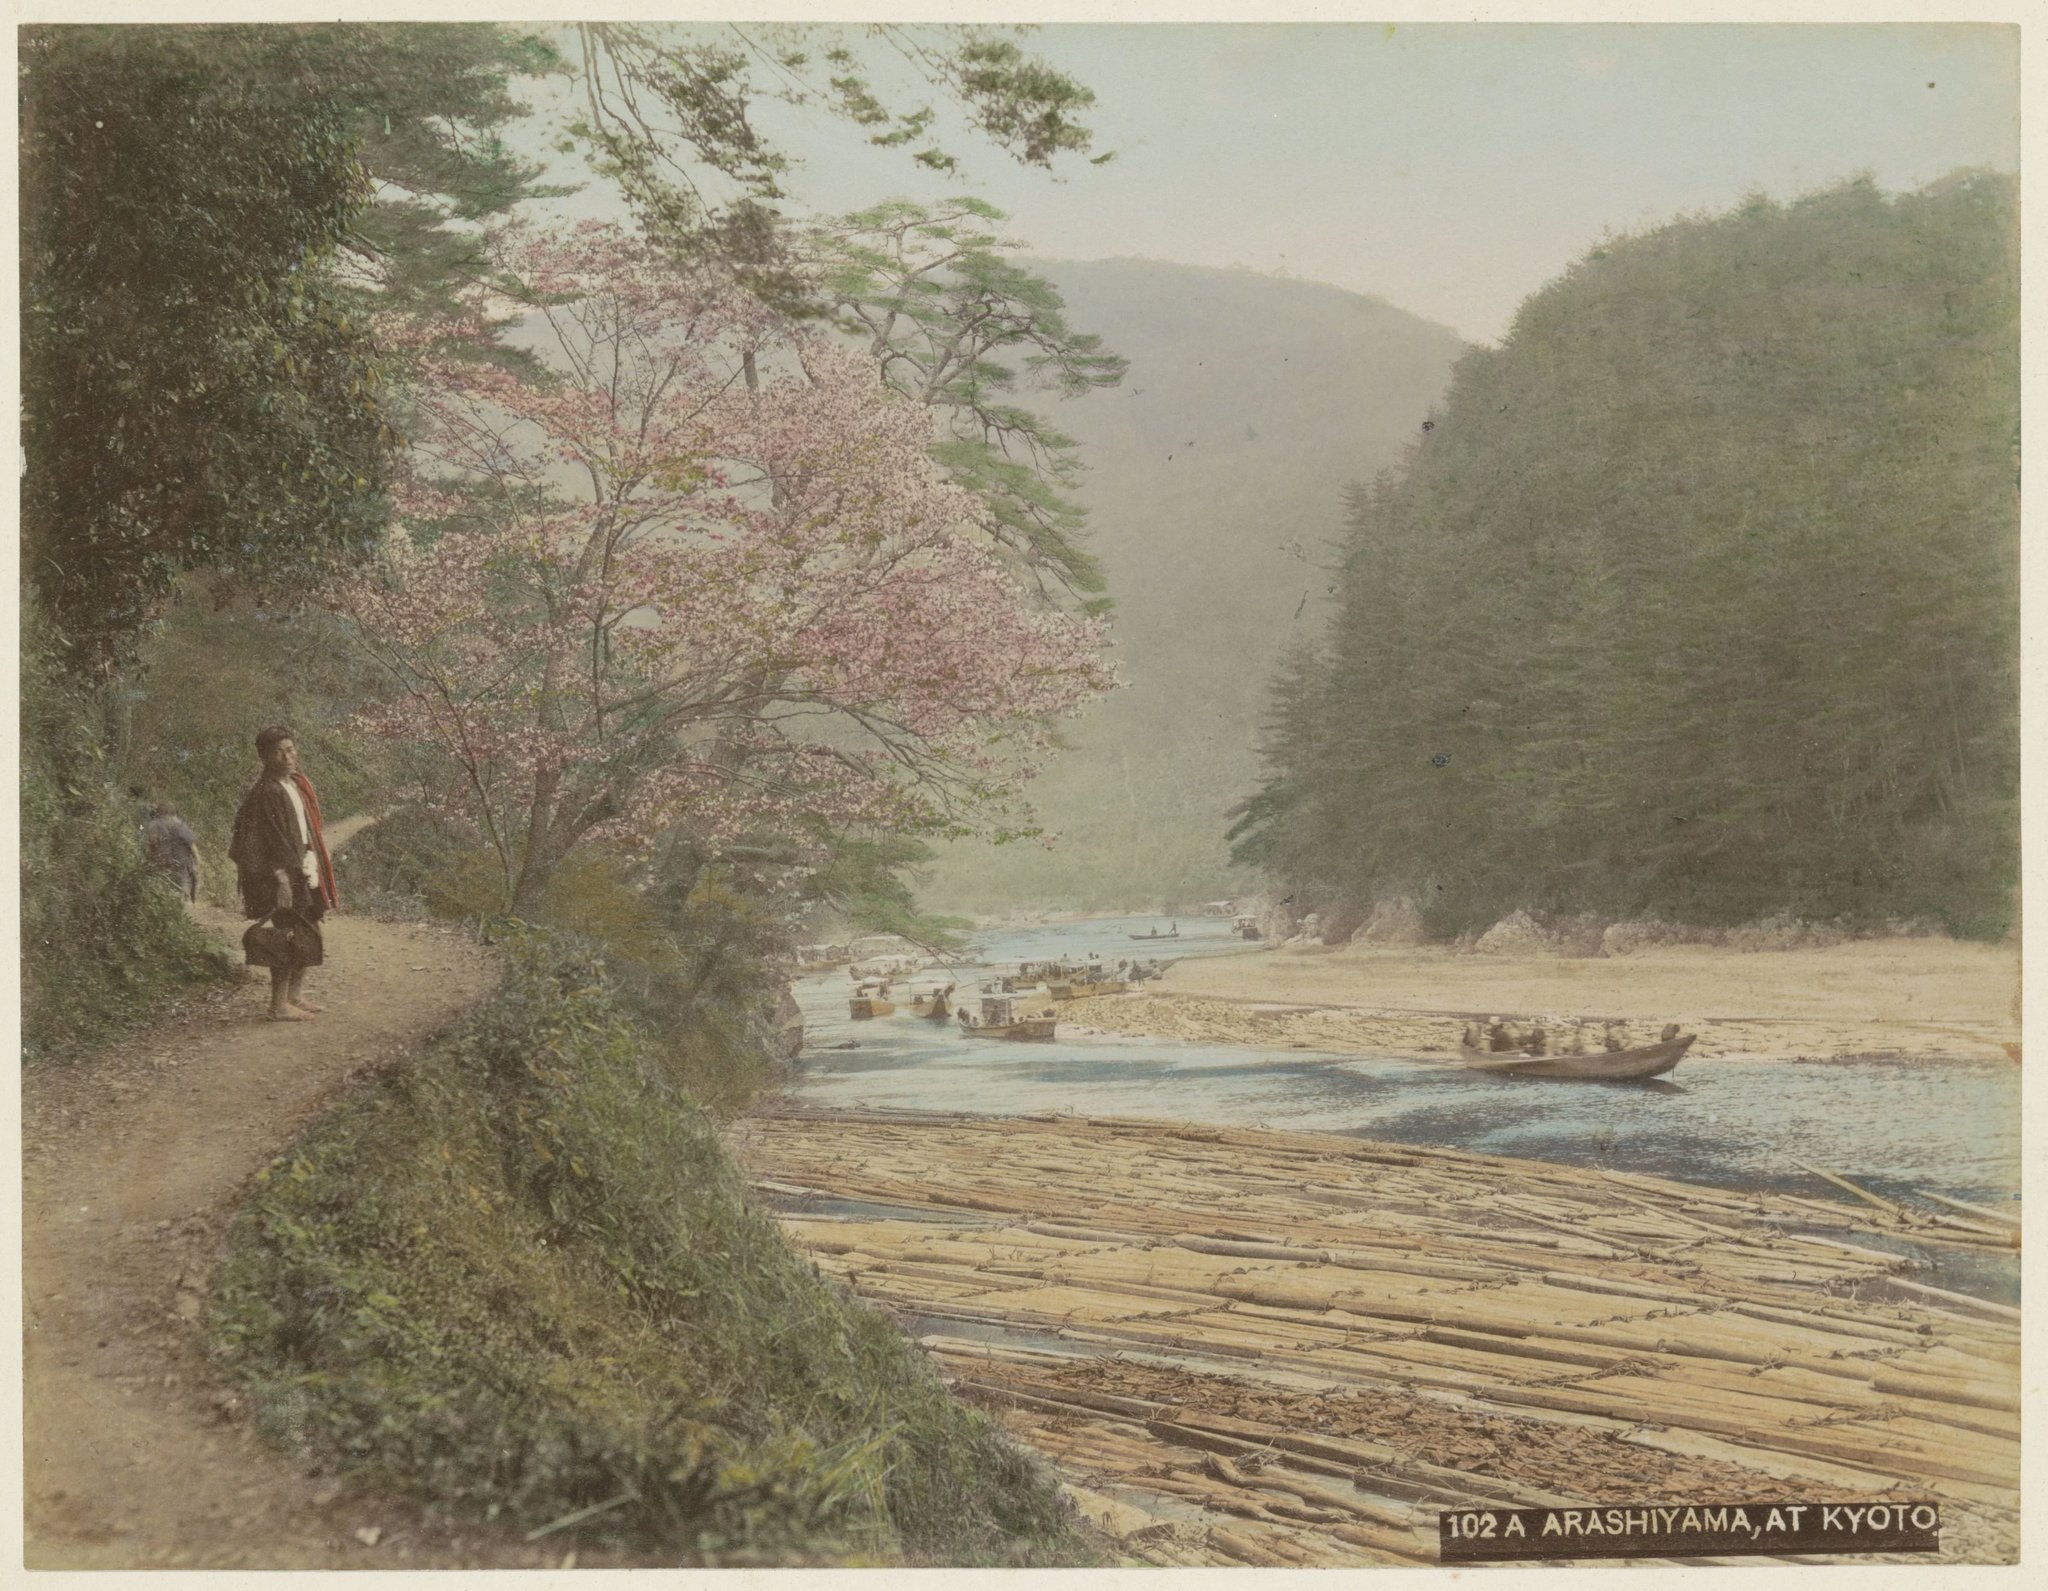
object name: photograph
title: Gezicht op een rivier met drijvende boomstammen en boten in Arashiyama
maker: Anonymous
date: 1870-1900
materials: cardboard, paper, photographic support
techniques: albumen print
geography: kyoto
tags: timber floating down the river, river (+ landscape with figures, staffage), kyoto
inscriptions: negative number: ‘102 A’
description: Onderdeel van Reisalbum met foto's van bezienswaardigheden in Japan.